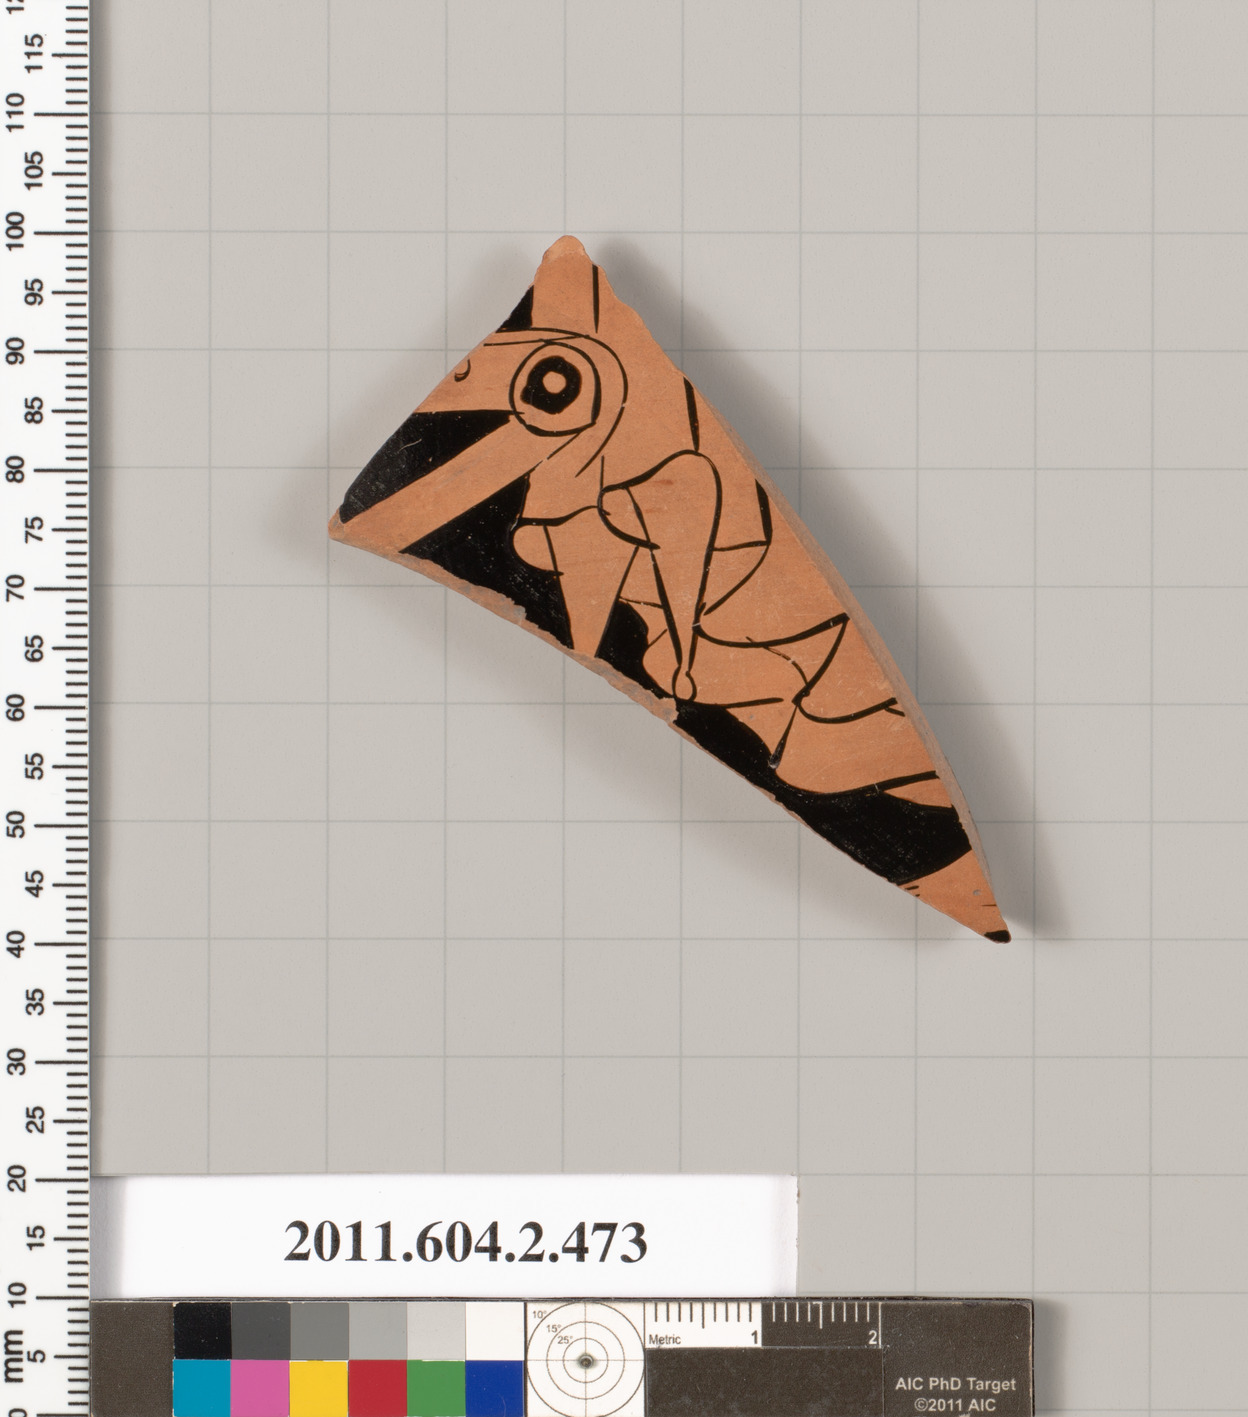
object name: column krater fragment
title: Terracotta fragment of a column-krater (bowl for mixing wine and water)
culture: greek, attic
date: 475-451 BCE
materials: terracotta